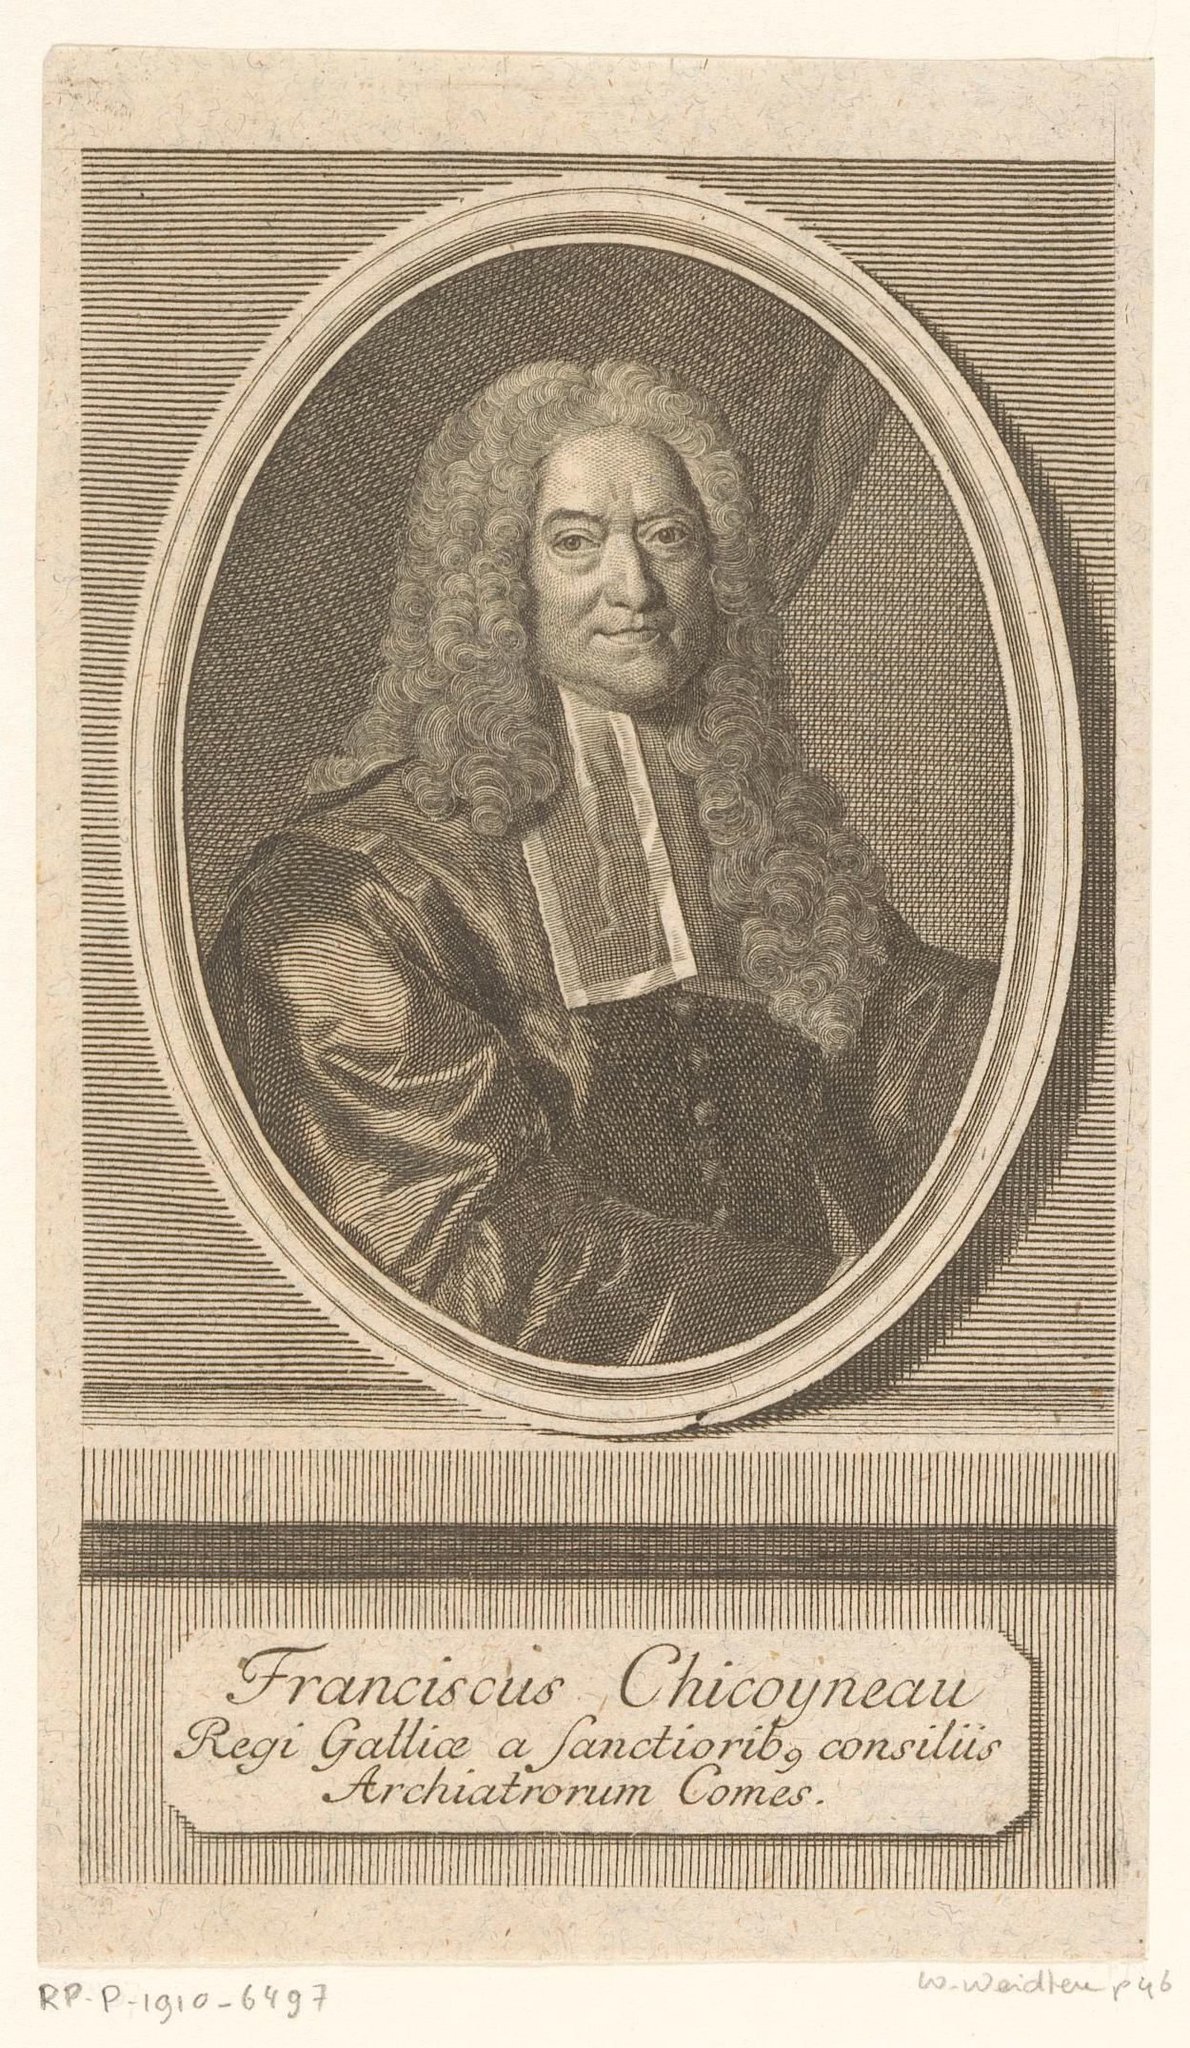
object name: print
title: Portret van François Chicoyneau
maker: johann martin bernigeroth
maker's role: print maker, publisher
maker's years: 1713-1767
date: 1746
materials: paper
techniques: engraving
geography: leipzig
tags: historical persons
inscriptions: collector's mark: Lugt 2228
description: Prent ook gebruikt in: Zuverlässige Nachrichten von dem gegenwärtigen Zustande, Veränderung und Wachsthum der Wissenschaften. dl. 81. Leipzig: Johann Friedrich Gleditsch, 1746.